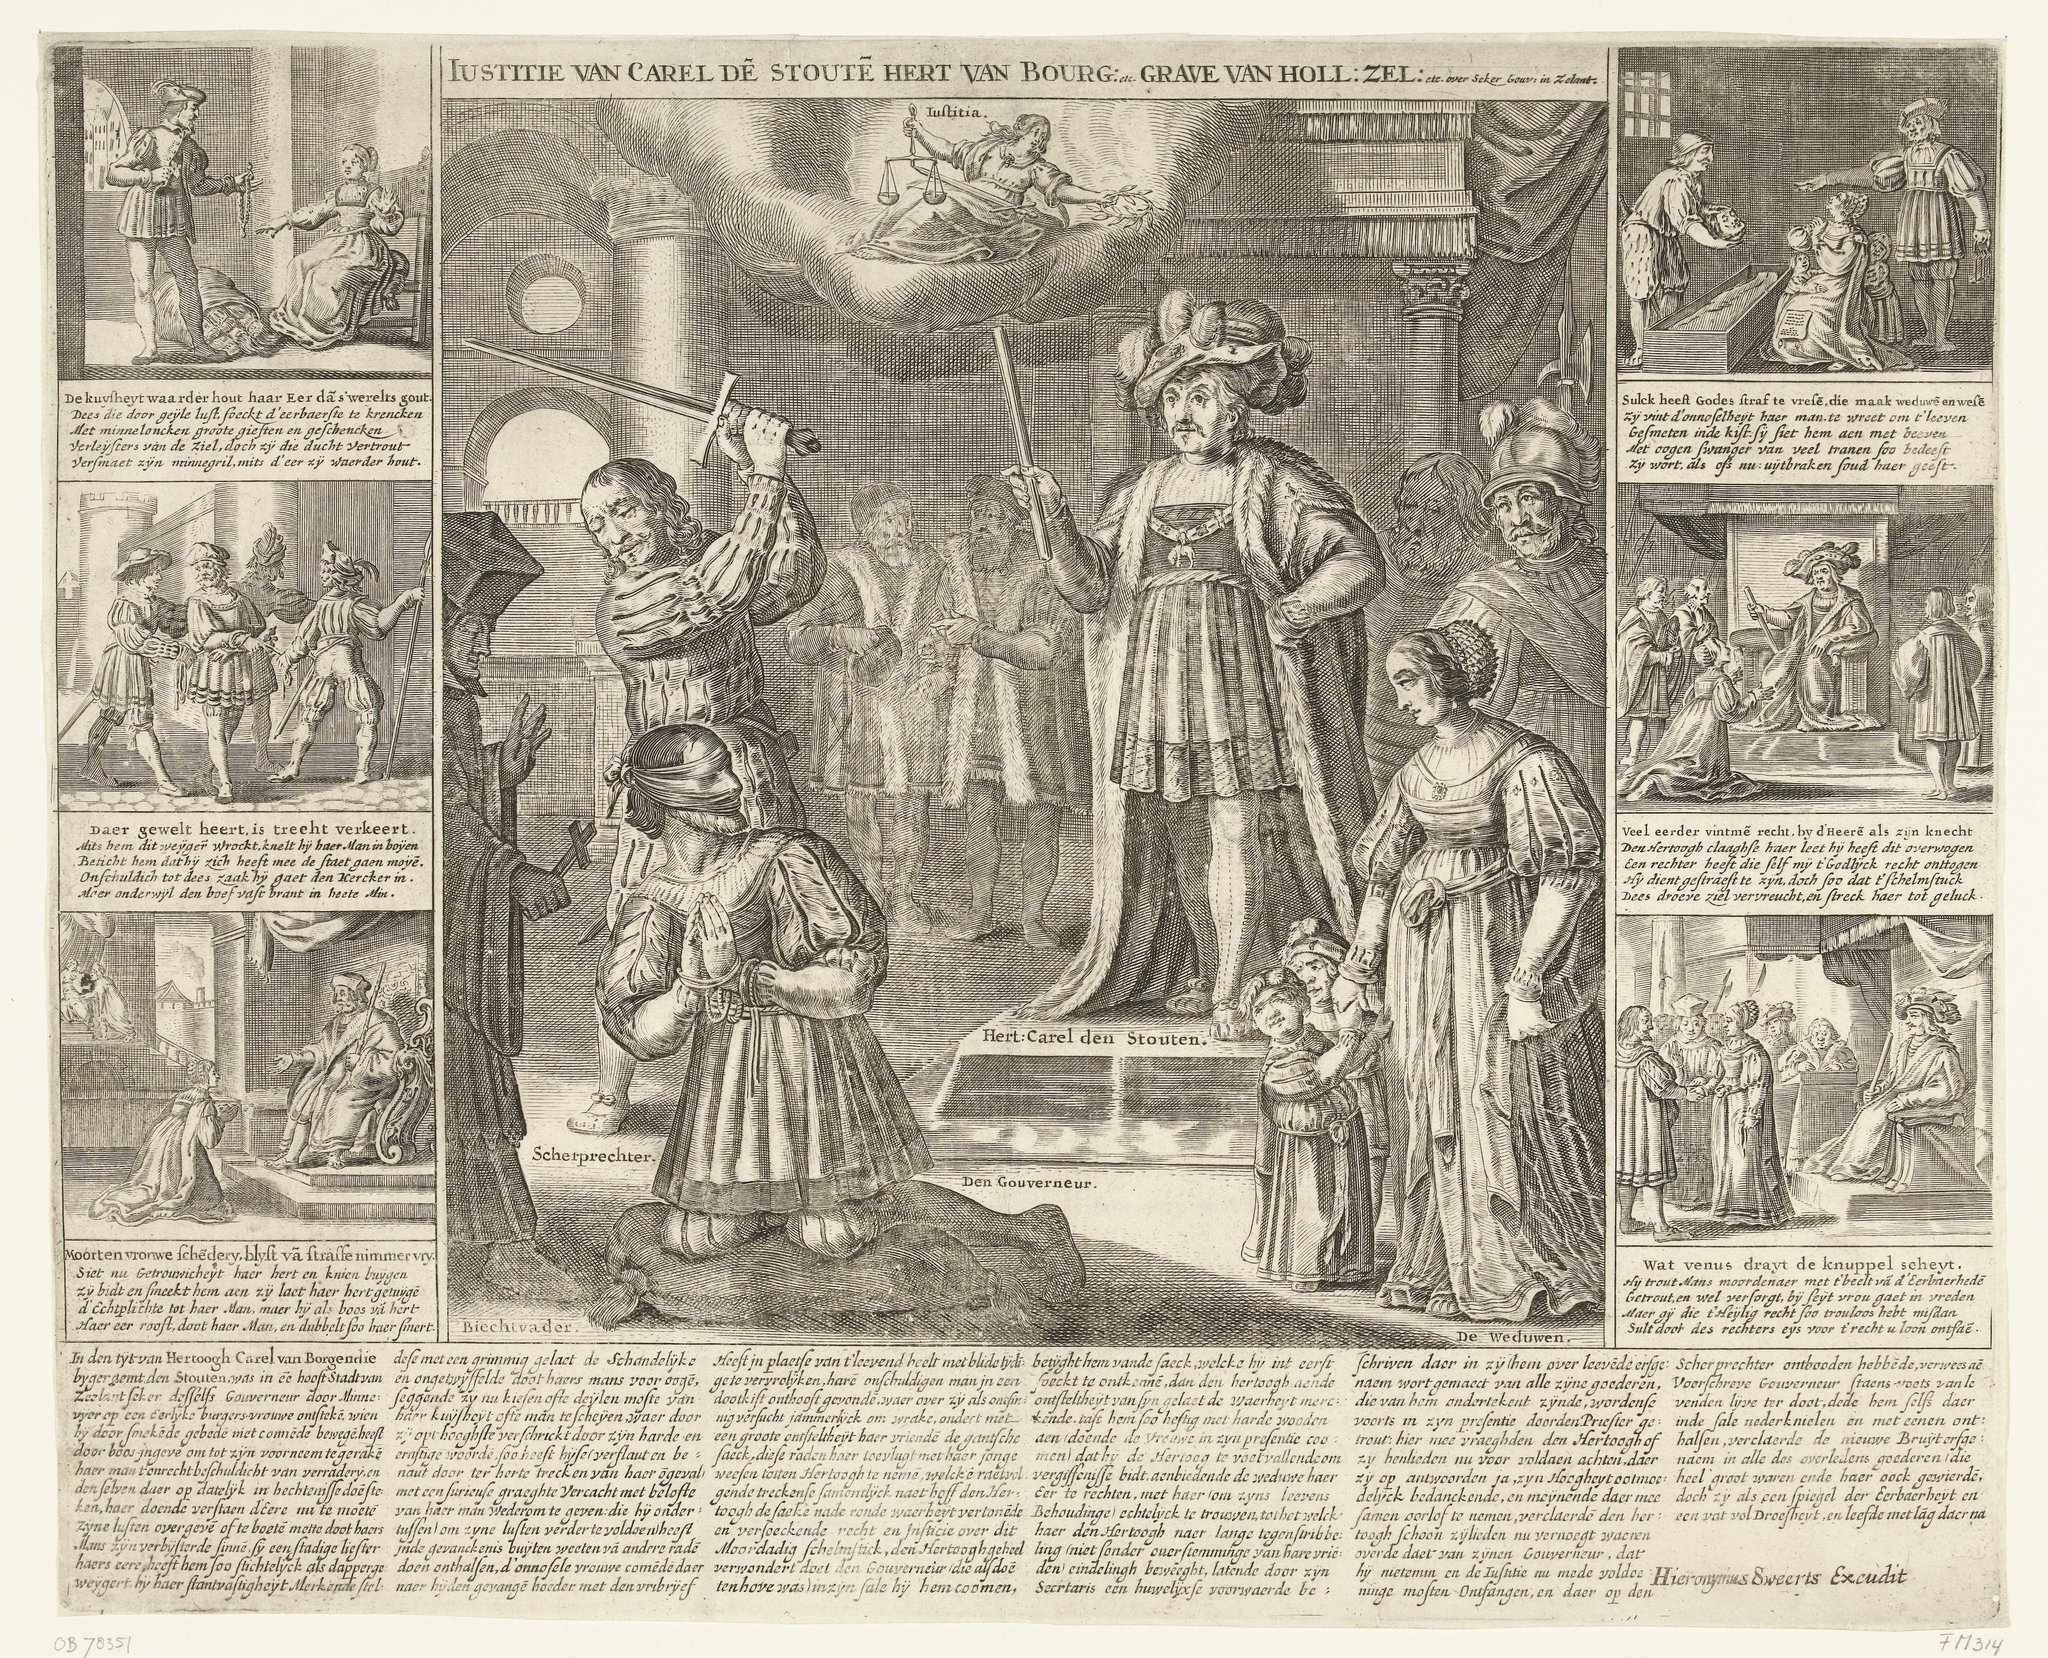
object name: history print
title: Iustitie van Carel de[n] Stoute[n] hert van Bourg. etc. grave van Holl: Zel: etc. over seker Gouv. in Zelant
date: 1660-1695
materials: paper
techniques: engraving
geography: northern netherlands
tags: earl, charles the bold (duke of burgundy), juridical examples; exemplary judges; 'gerechtigkeitsbilder', zeeland, burgundian netherlands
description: Rechtspraak van Karel de Stoute over de gouverneur van Zeeland, ca. 1474. De gouverneur van Zeeland (of Gelderland) doodt de man (P. Stalins) en verkracht de weduwe. De hertog dwingt de gouverneur eerst met de weduwe te trouwen en laat hem vervolgens onthoofden. Ook bekend als het verhaal van Rhynsault en Saphira.